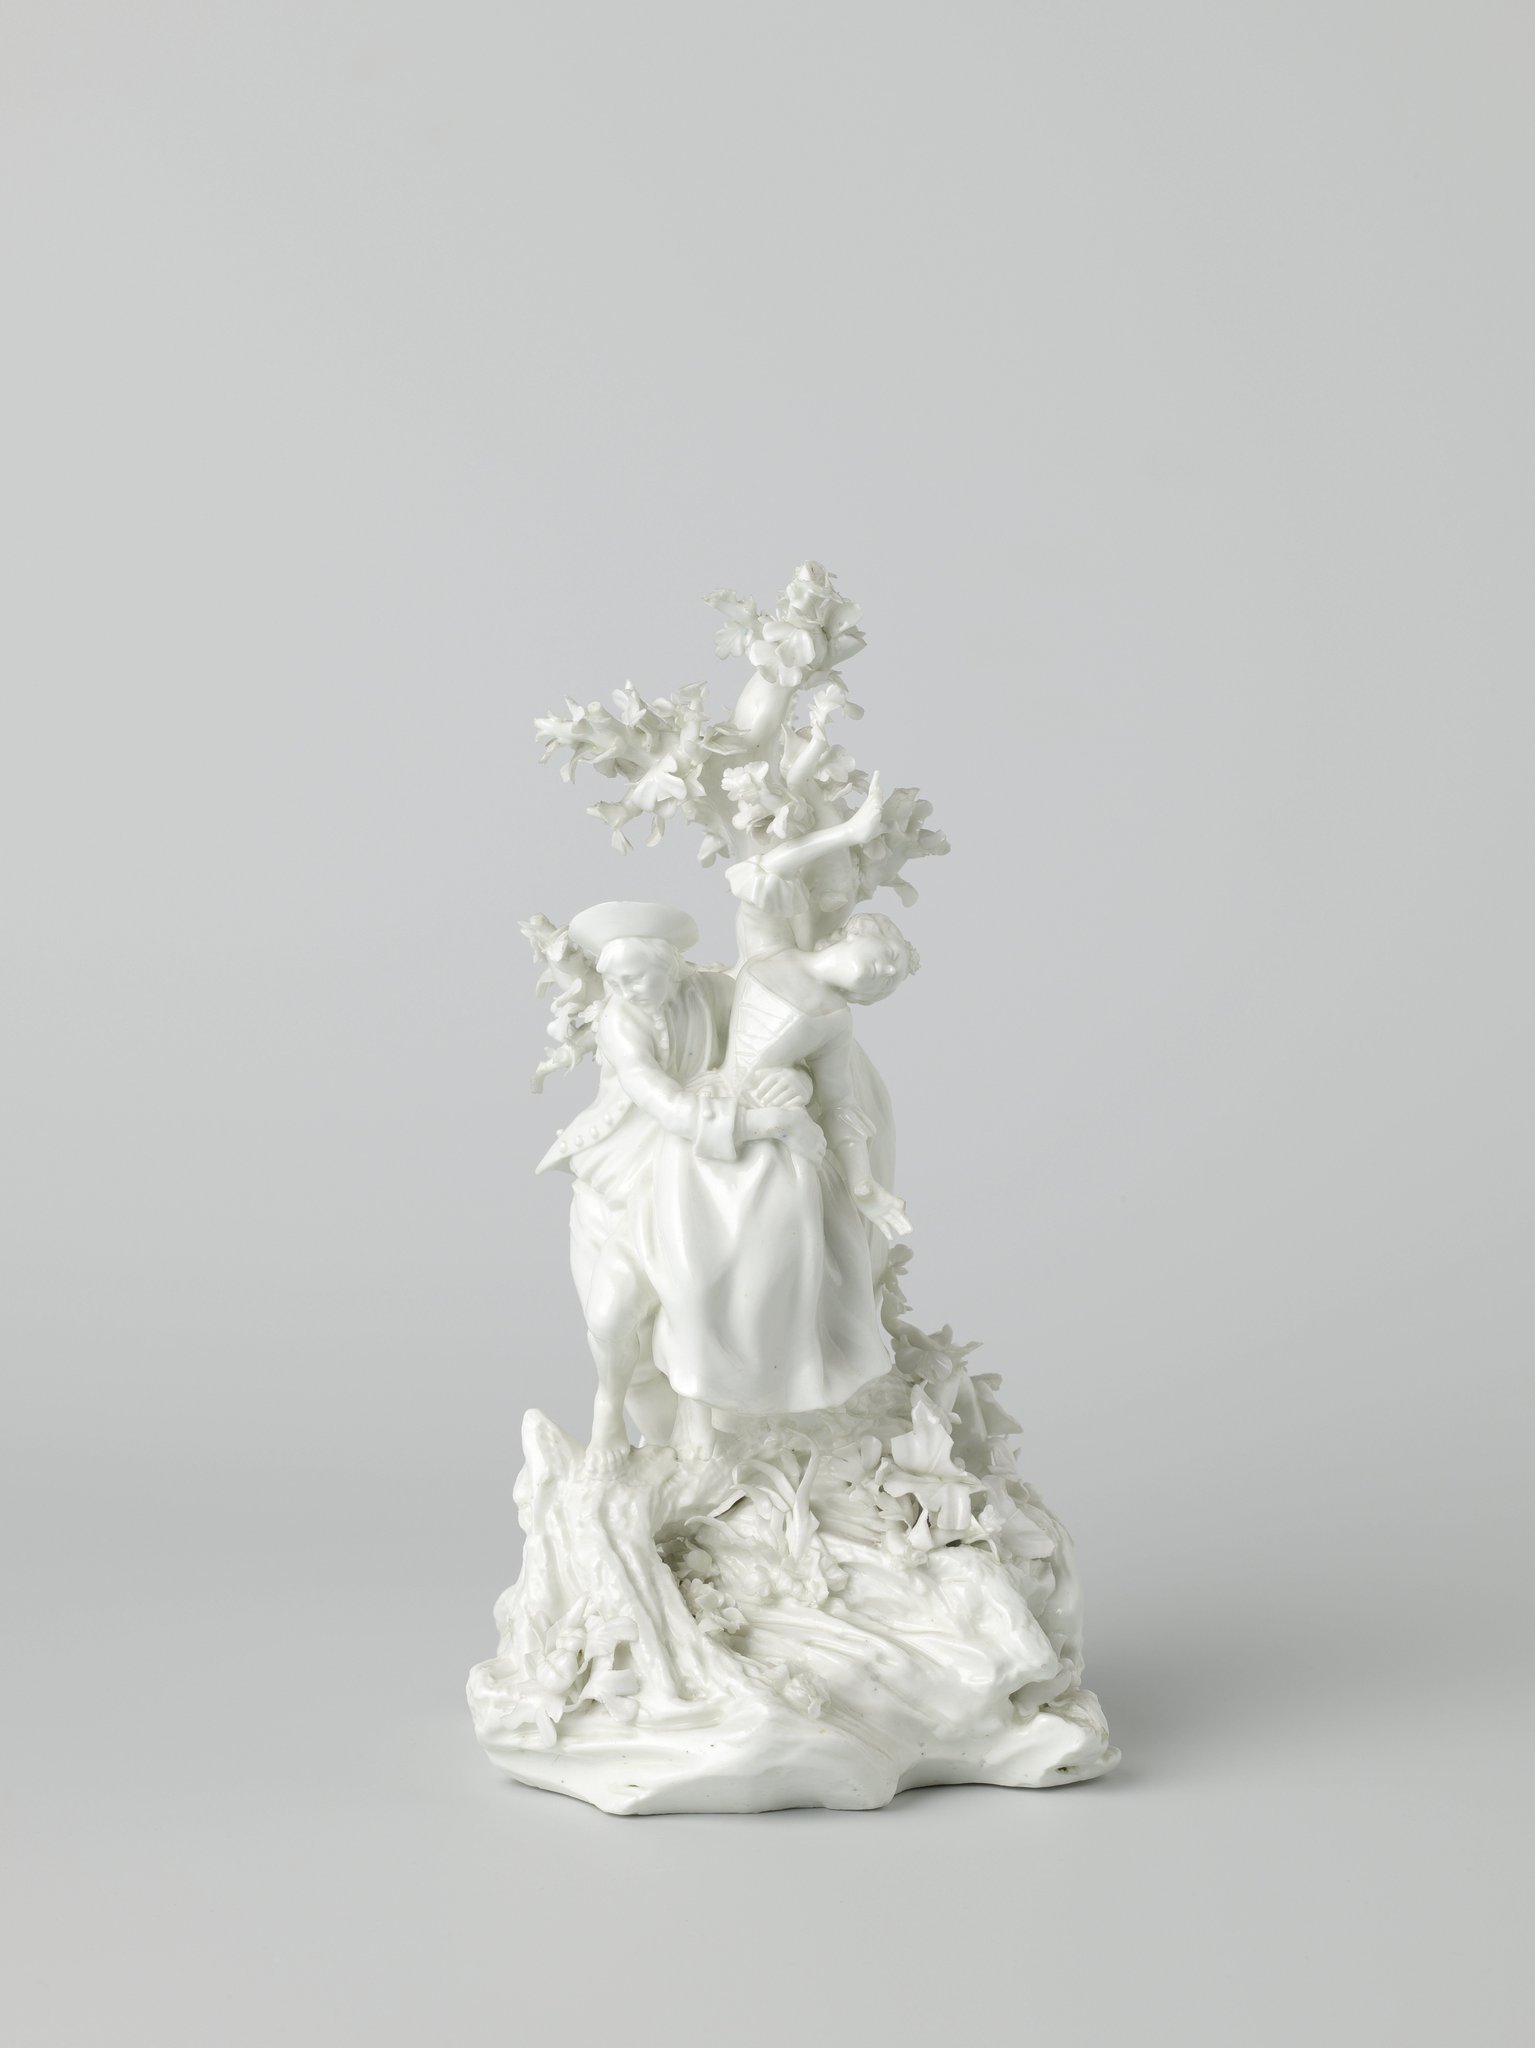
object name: figure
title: Figure of the taking of a shepherdess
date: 1755-1780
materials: glaze, paint, porcelain, soft paste porcelain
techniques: firing, forming, vitrification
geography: doornik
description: Group. Soft-paste porcelain. Tournai, c. 1755 - 1780, factory of François Joseph Peterinck.